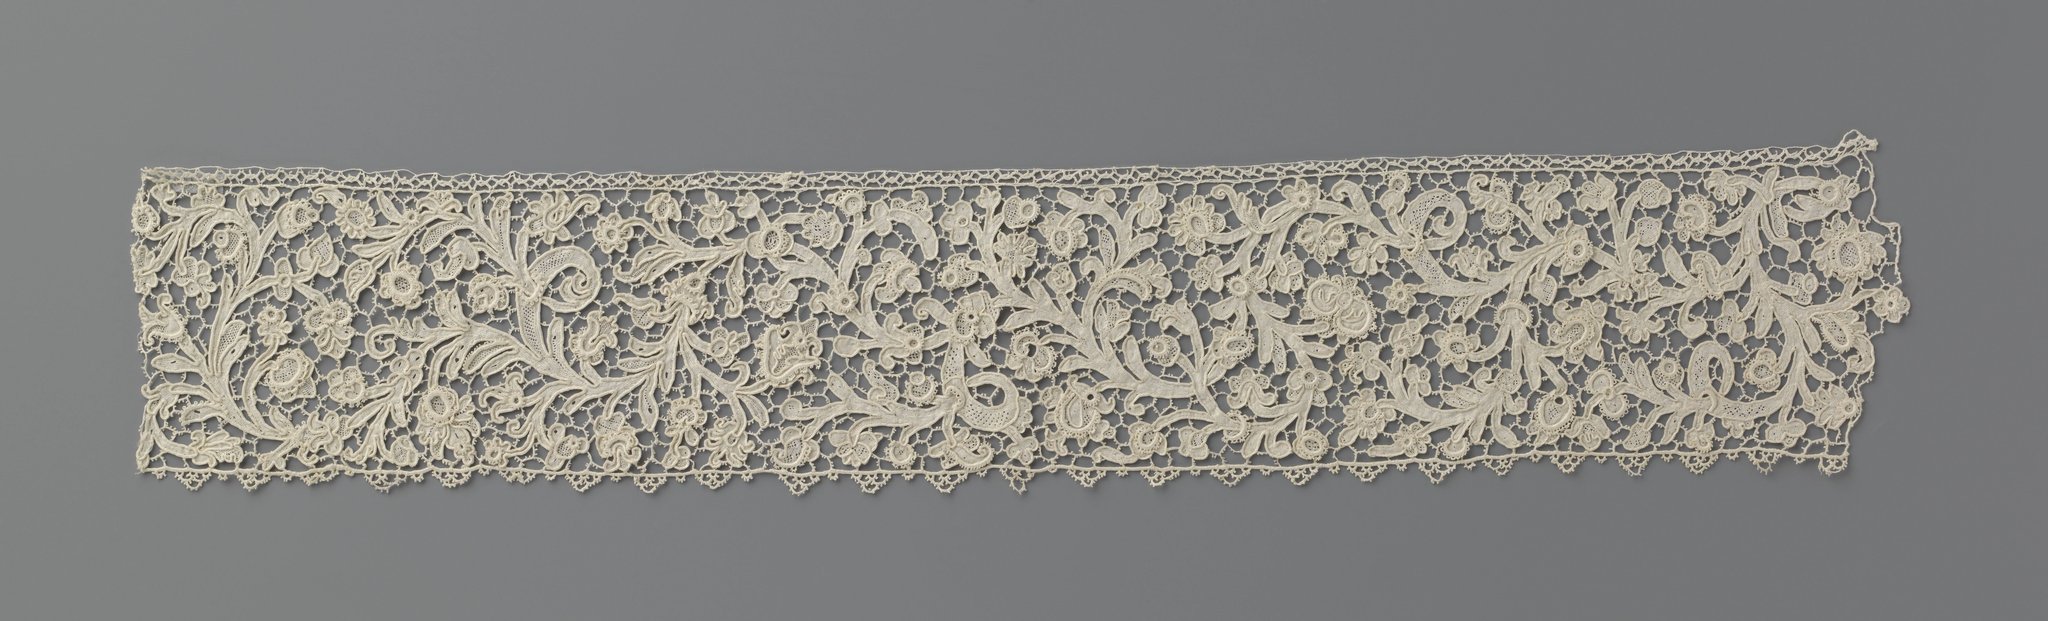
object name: strip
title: Strook naaldkant met gepluimde ranken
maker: Anonymous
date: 1875-1895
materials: linen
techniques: rose point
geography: burano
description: Strook naturelkleurige naaldkant: Venetiaanse rozenkant. Op een spijlengrond met zeszijdige mazen staan rijkvertakte, naar links en rechts zwenkende ranken, soms toegewend, soms lopend. Hieraan groeien veelsoortige, zorgvuldig gedetailleerde knopvormige bloempjes. Hier en daar is de top van een rank door een opening in de tak heen gegroeid. Rechte afwerking van beurtelings een oogje en een driehoek.